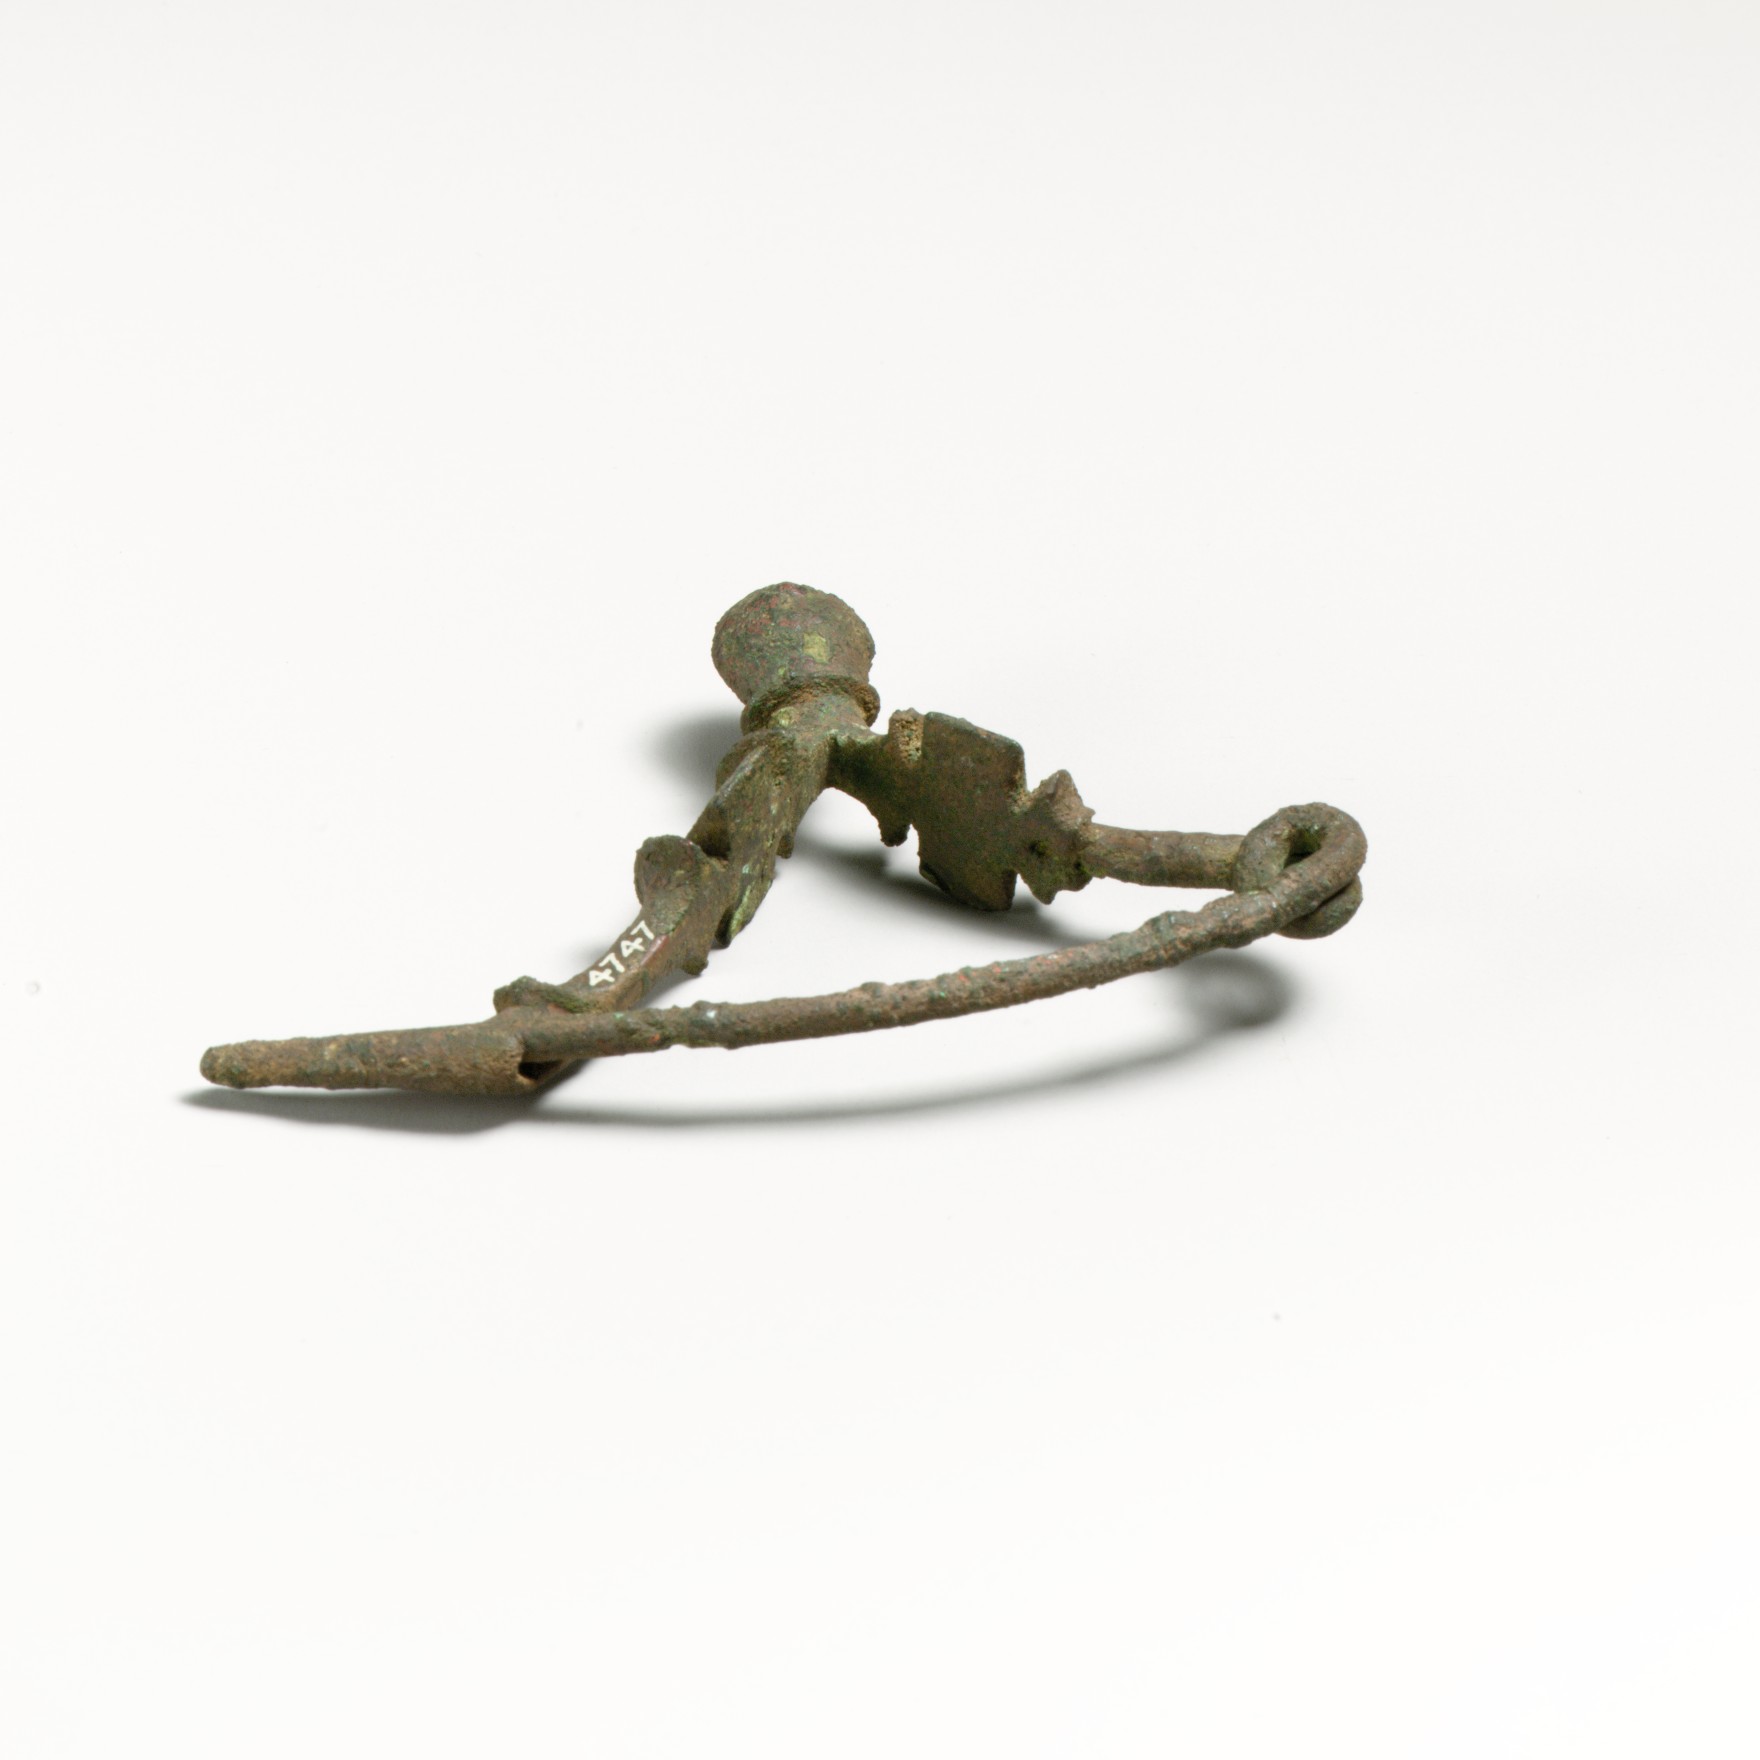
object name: fibula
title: Bronze fibula (safety pin)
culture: cypriot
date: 800-701 BCE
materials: bronze